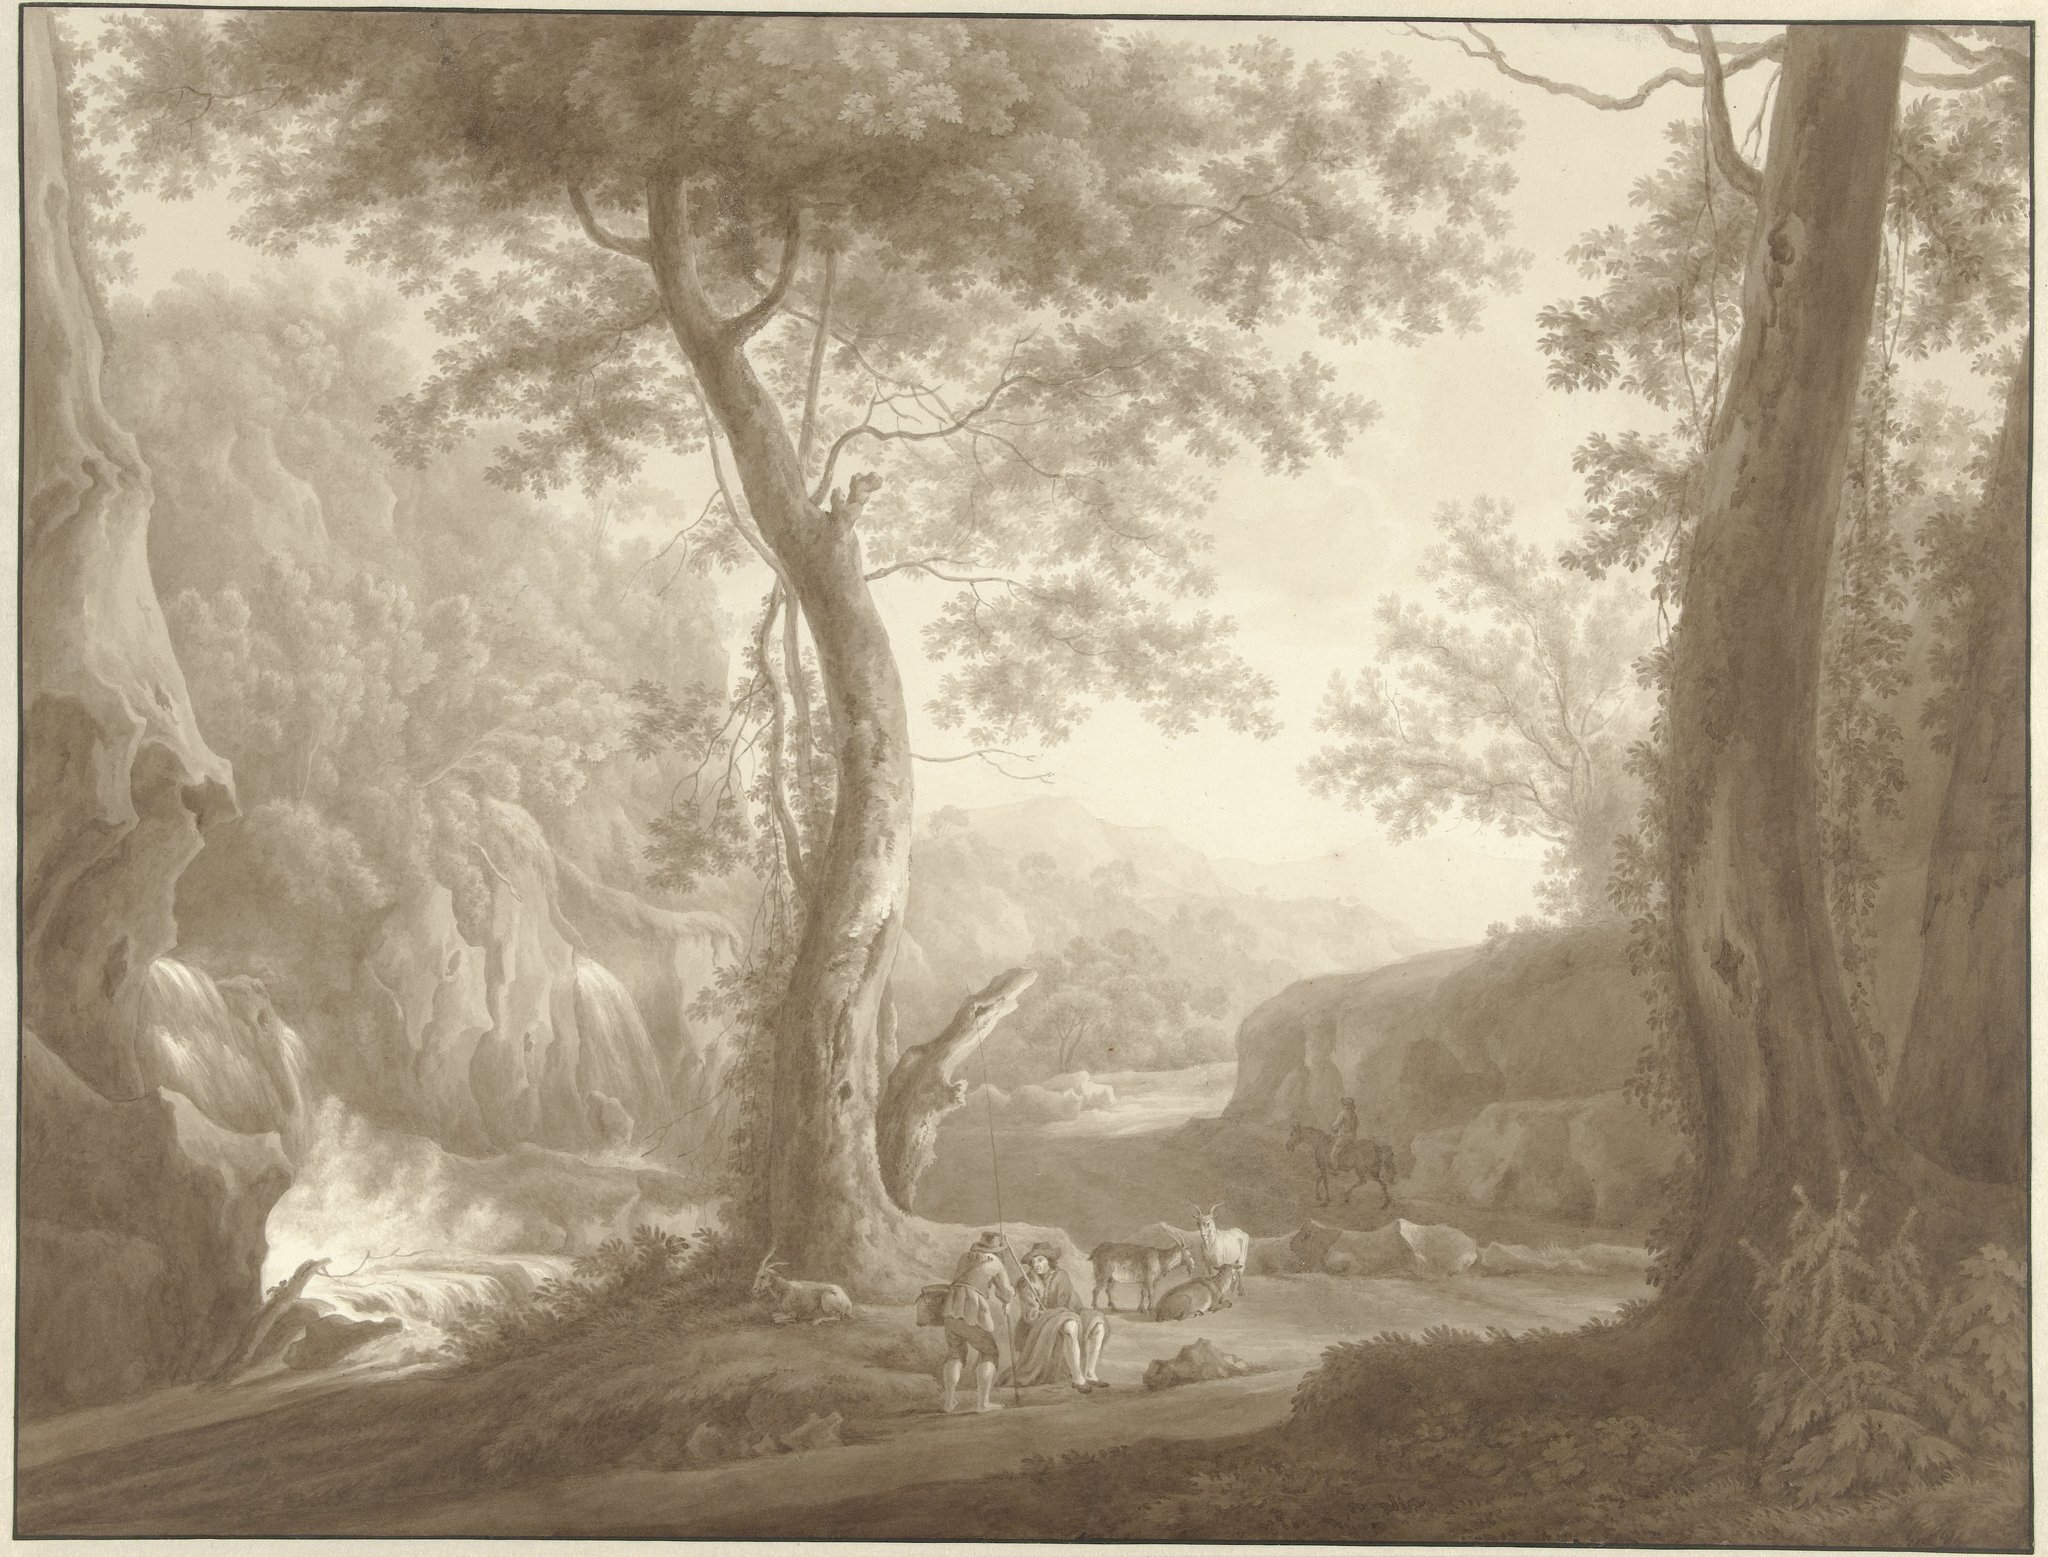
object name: drawing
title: Berglandschap met geitenhoeder en reiziger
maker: w. regnu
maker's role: draughtsman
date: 1628-1702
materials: paper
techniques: brush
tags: herding, herdsman, herdswoman, shepherd, shepherdess, cowherd, etc., mountains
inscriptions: : ‘Dessiné d'après Tableau original / de J: Both / N= 110 / 1 B.J.K.M. / W. Regnu’